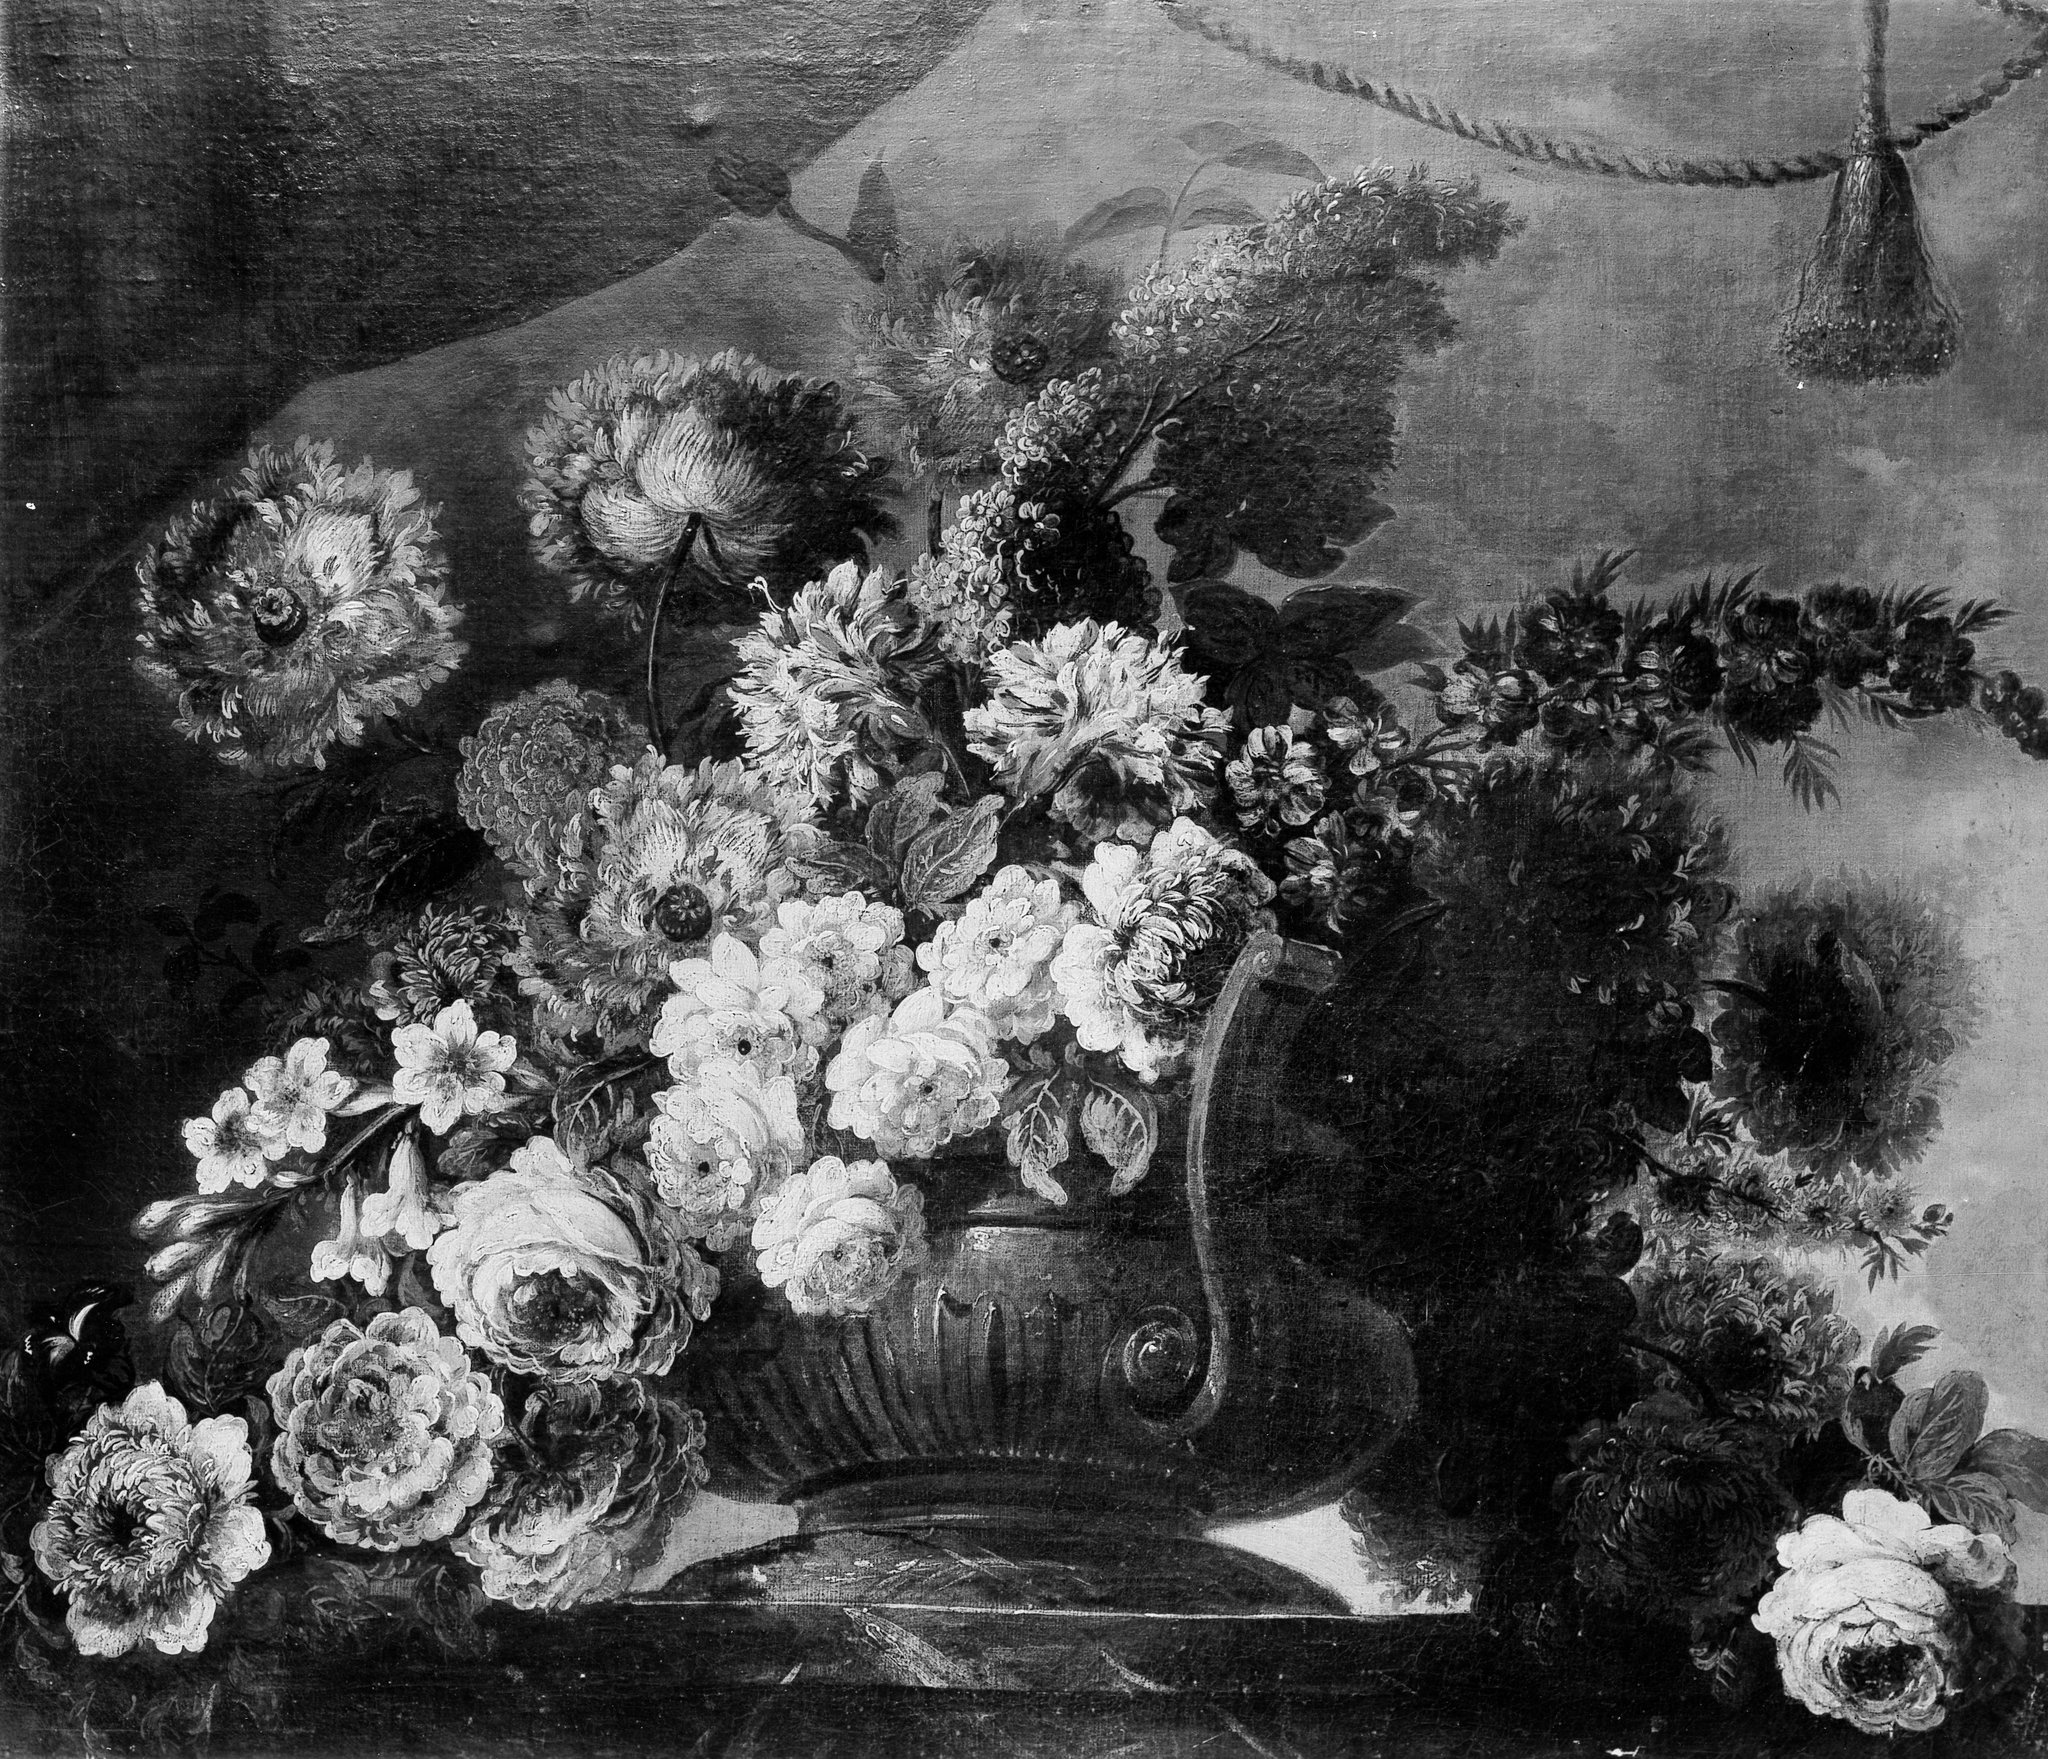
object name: overdoor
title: Vase of Flowers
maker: jean-baptiste belin de fontenay the elder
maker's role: artist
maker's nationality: french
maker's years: 1653-1715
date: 1667-1700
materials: canvas, oil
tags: flowers,roses